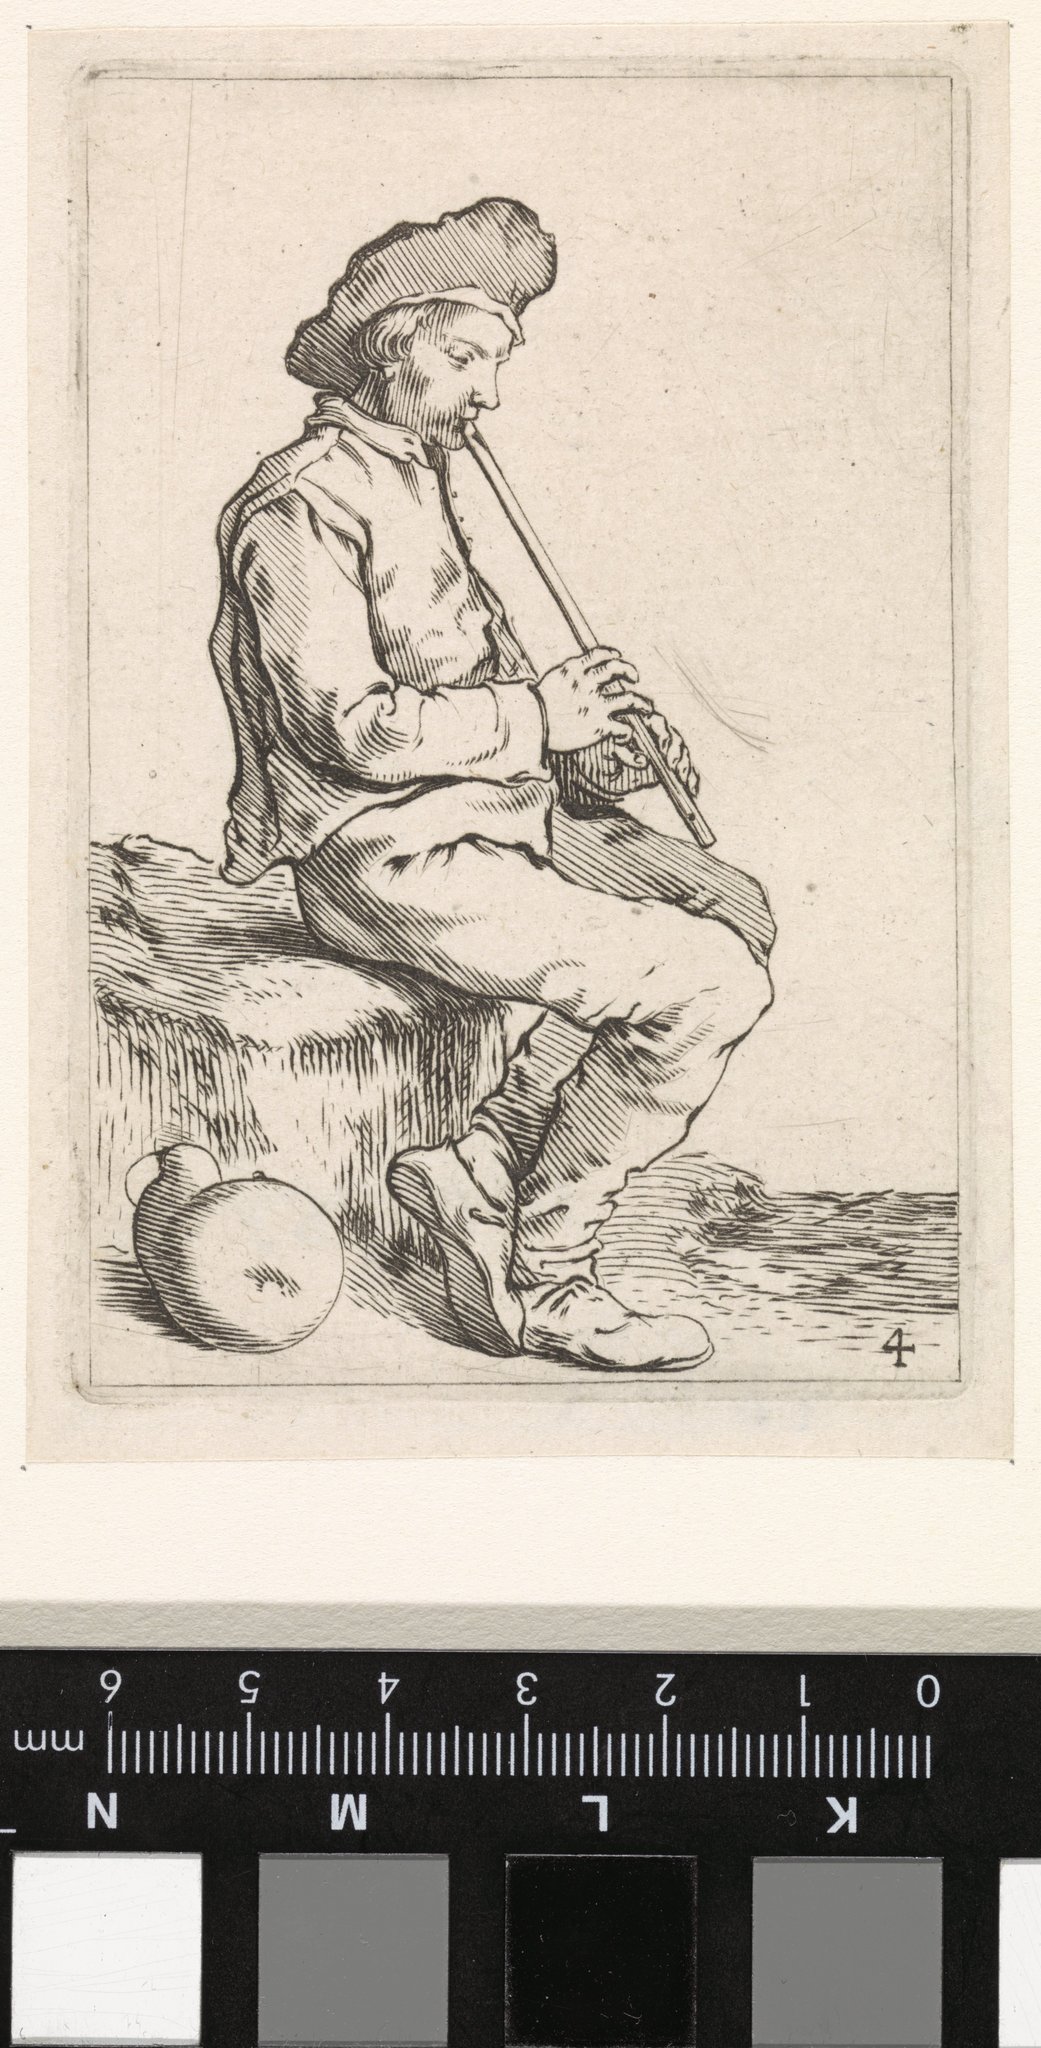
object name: print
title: Boeren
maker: cornelis saftleven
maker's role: draughtsman, painter, print maker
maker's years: 1607-1681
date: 1645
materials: paper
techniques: etching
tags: head-gear: beret (+ men's clothes), farmers, flute, aulos, tibia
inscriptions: collector's mark: Lugt 240